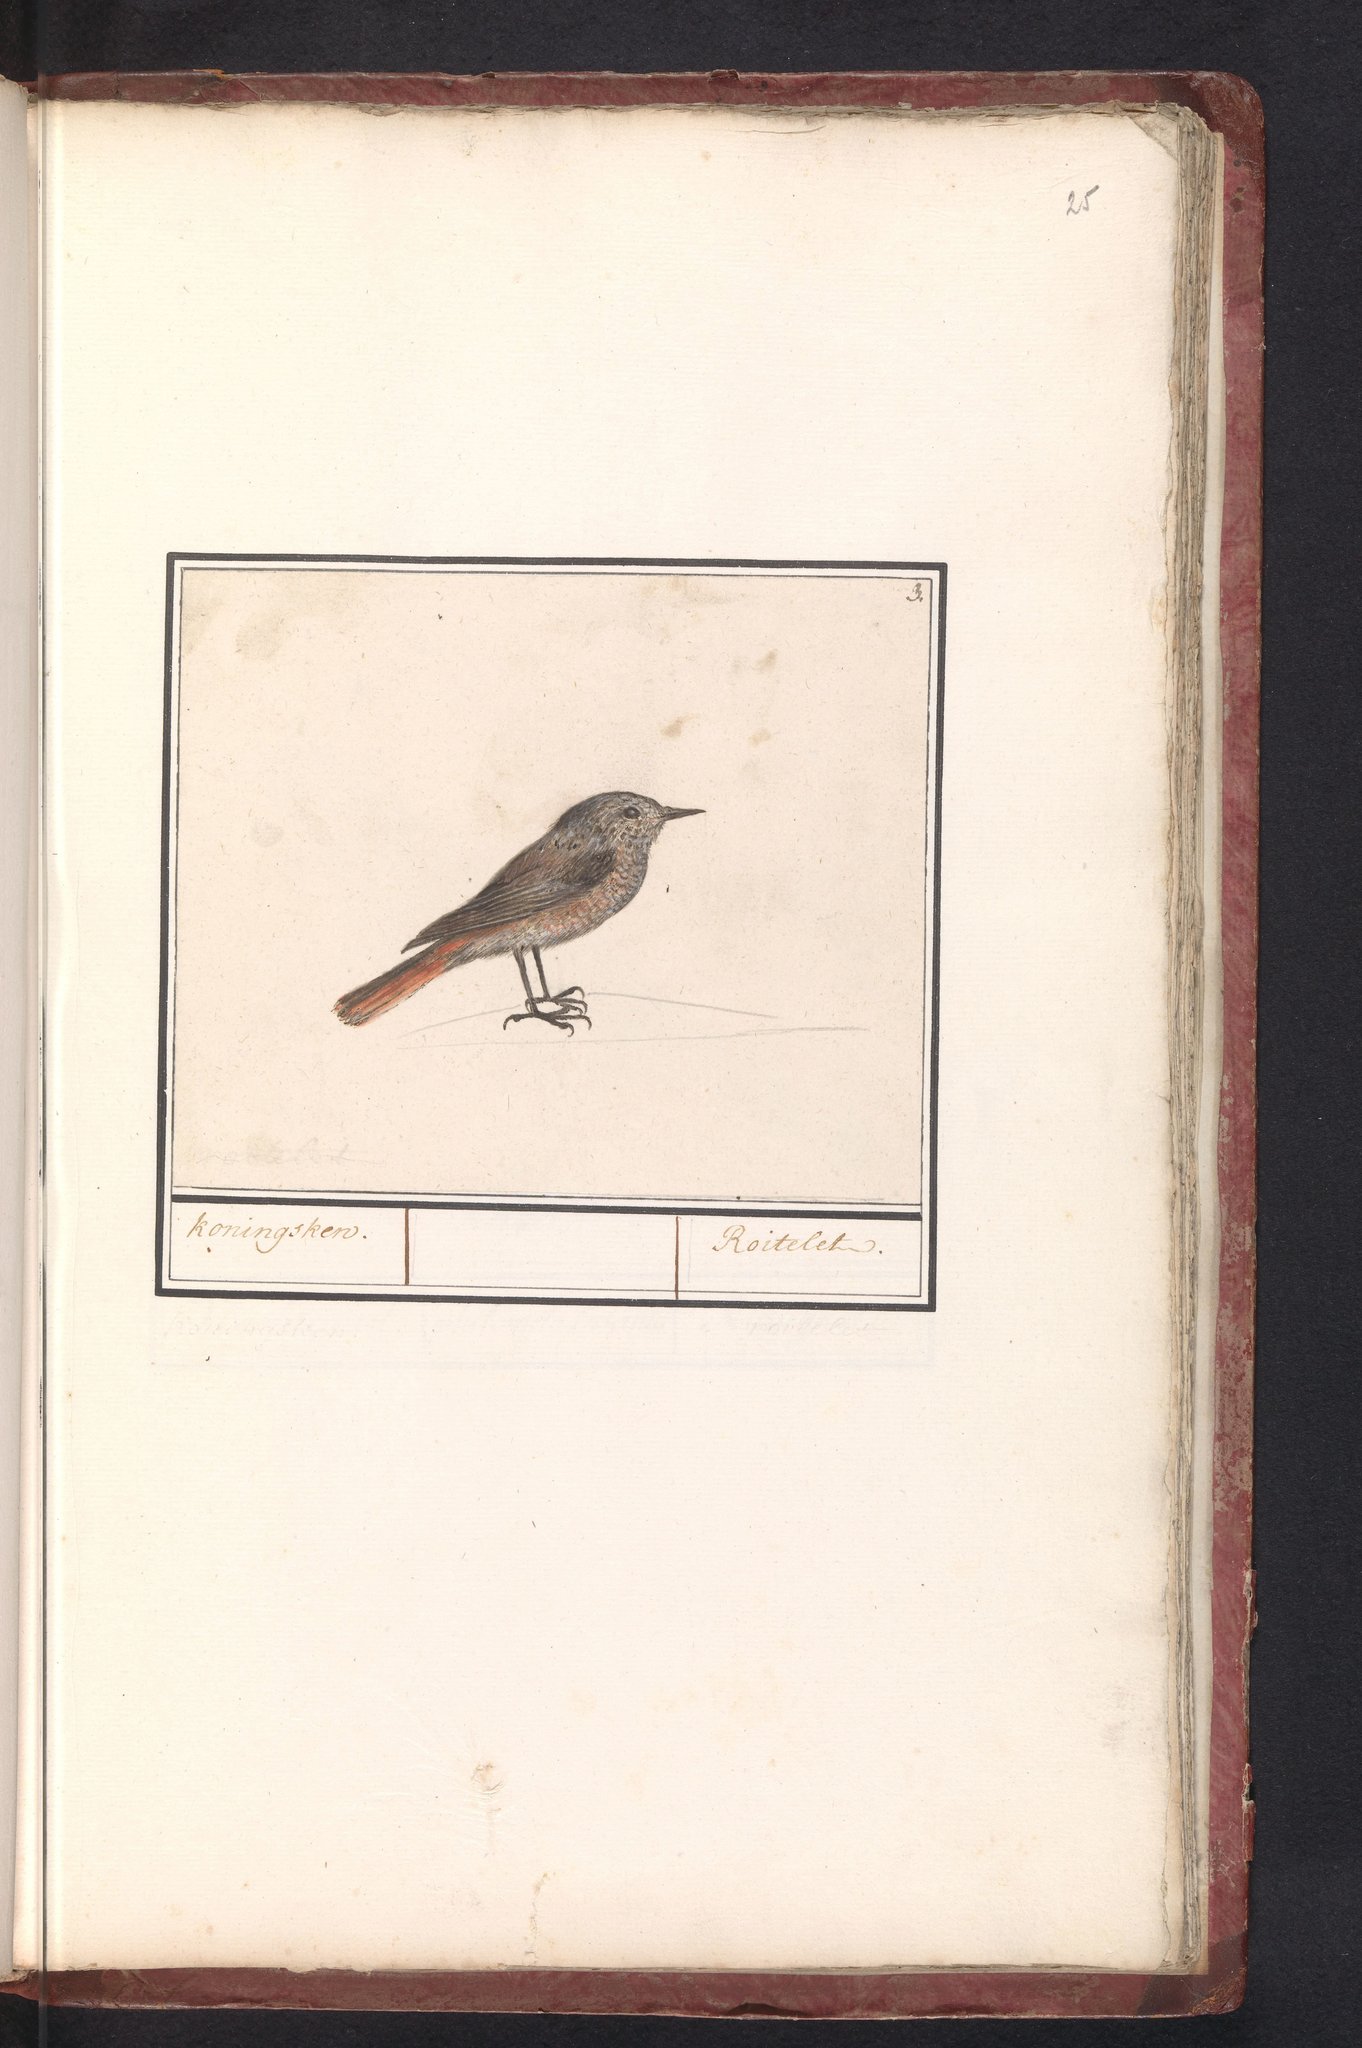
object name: drawing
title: Vogeltje, mogelijk een winterkoninkje (Troglodytes troglodytes)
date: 1596-1610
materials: paint, paper, pencil, watercolor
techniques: brush, pen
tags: song-birds: lark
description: Vogeltje, mogelijk een winterkoninkje. De Franse naam (roitelet) verwijst naar een goudhaantje, wat het zeker niet is. Genummerd rechtsboven: 3. Onderdeel van het tweede album met tekeningen van vogels. Vierde van twaalf albums met tekeningen van dieren, vogels en planten bekend rond 1600, gemaakt in opdracht van keizer Rudolf II. Met toelichting in Nederlands, Latijn en Frans.